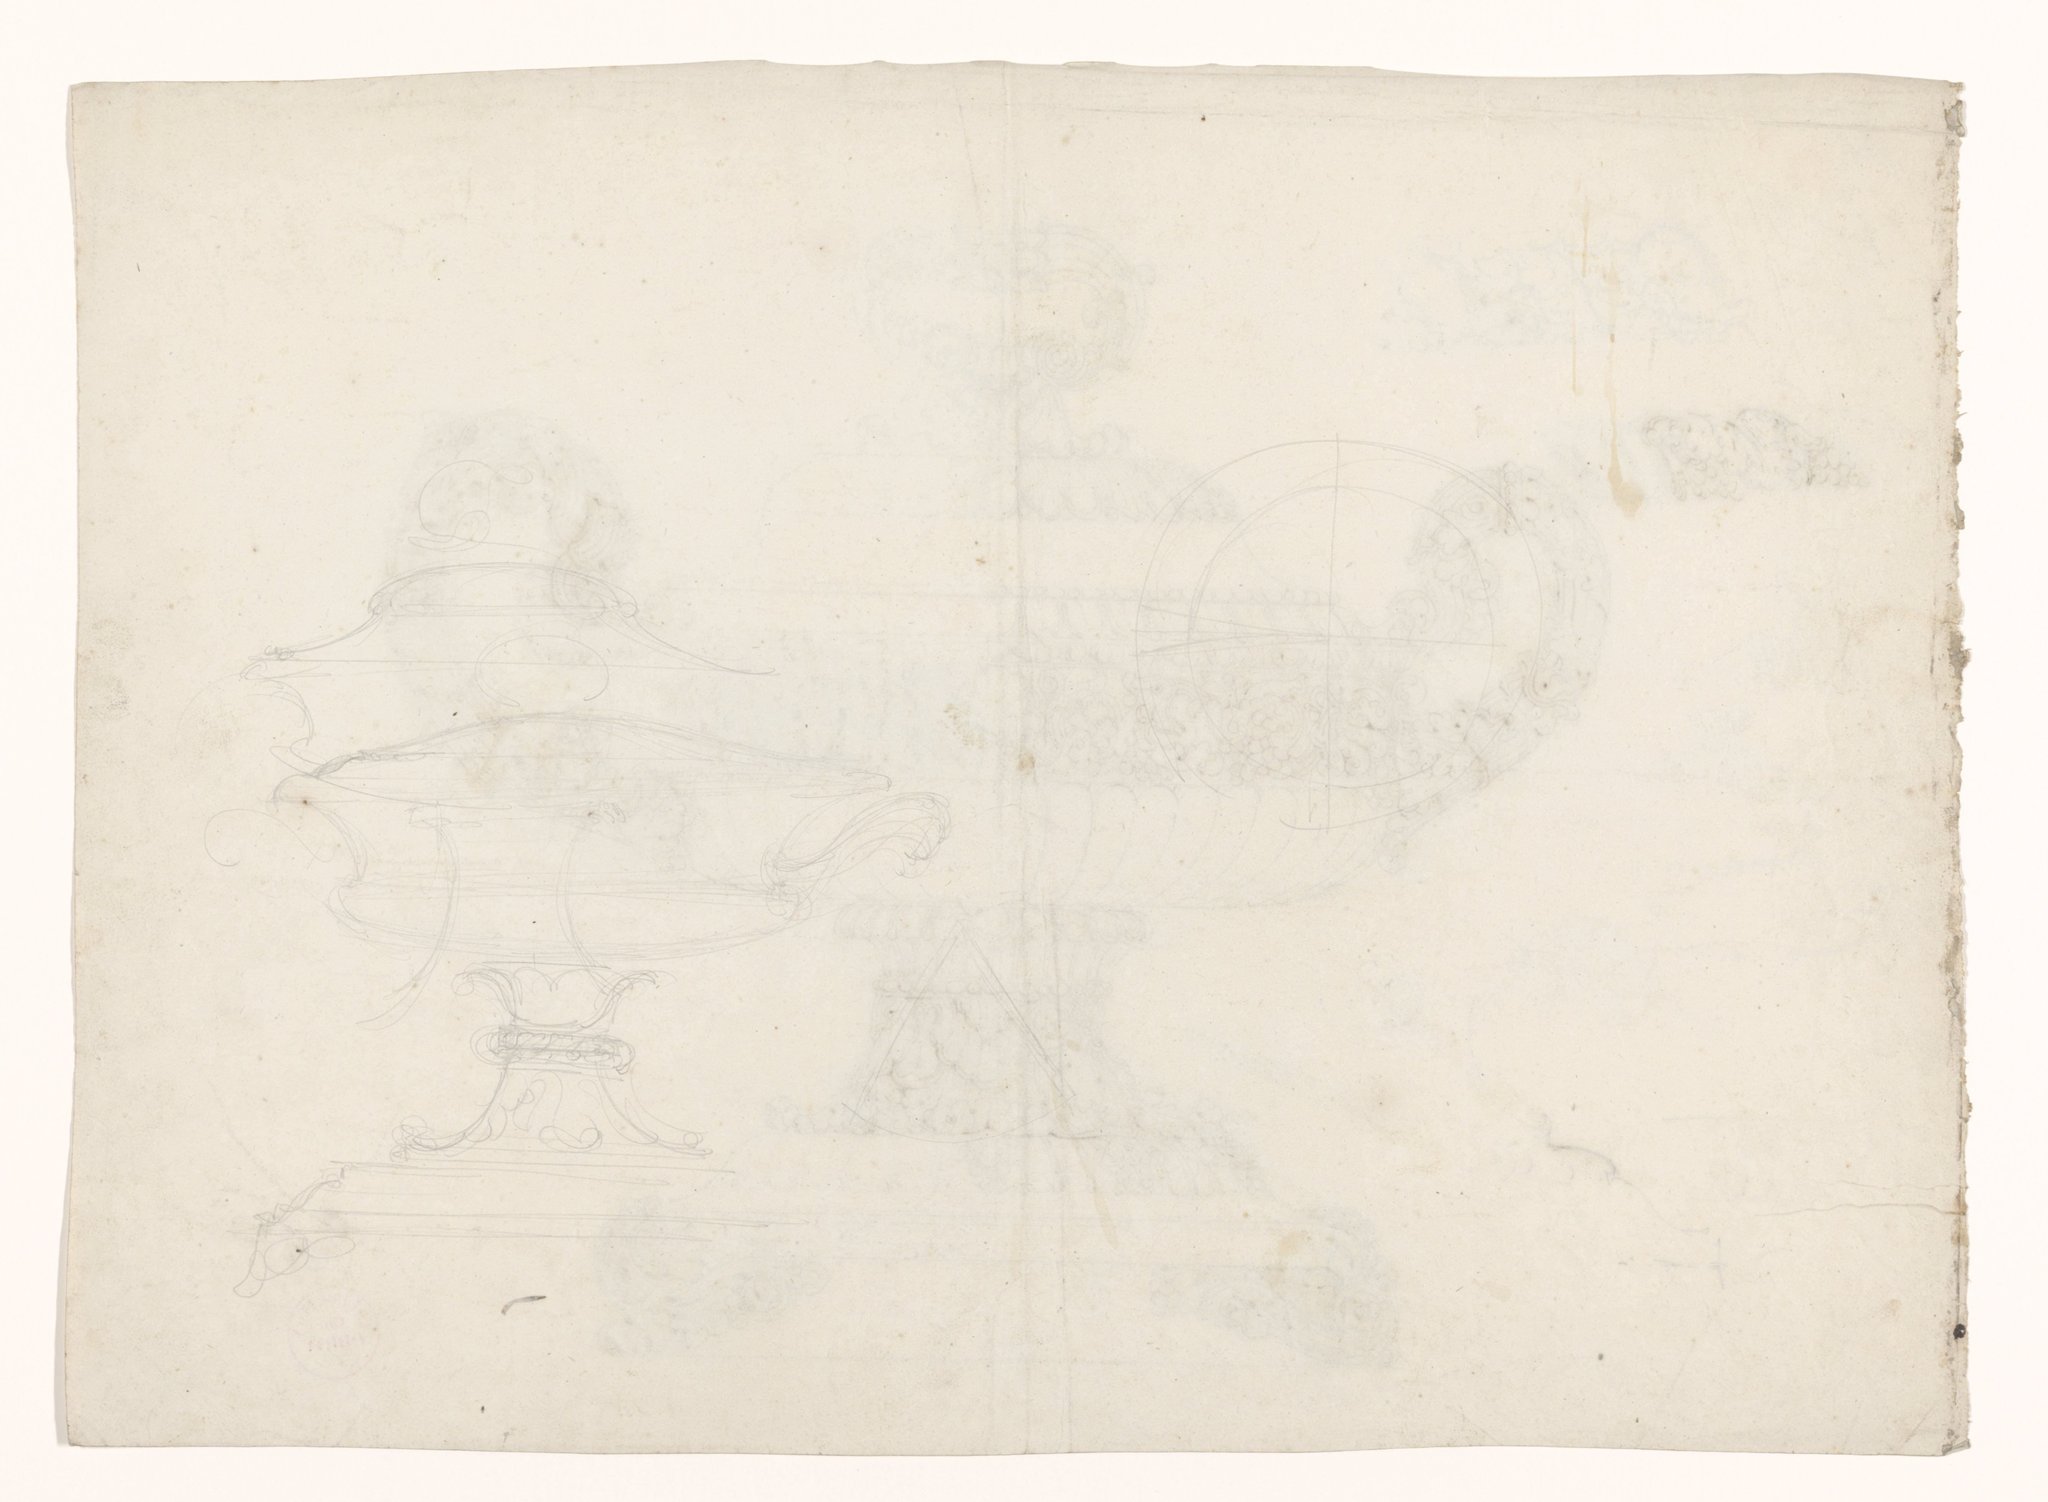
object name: design drawing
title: Ontwerp voor terrine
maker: charles nicolas odiot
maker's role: jeweler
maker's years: 1789-1869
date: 1825-1830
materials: ink, paper, pencil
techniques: drawing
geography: paris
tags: containers, dinner-service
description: Naast het grote ontwerp voor de terrine diverse schetsen in potlood voor friezen en voor de vorm van de terrine; rechtsonder een berekening in pen en bruine inkt.